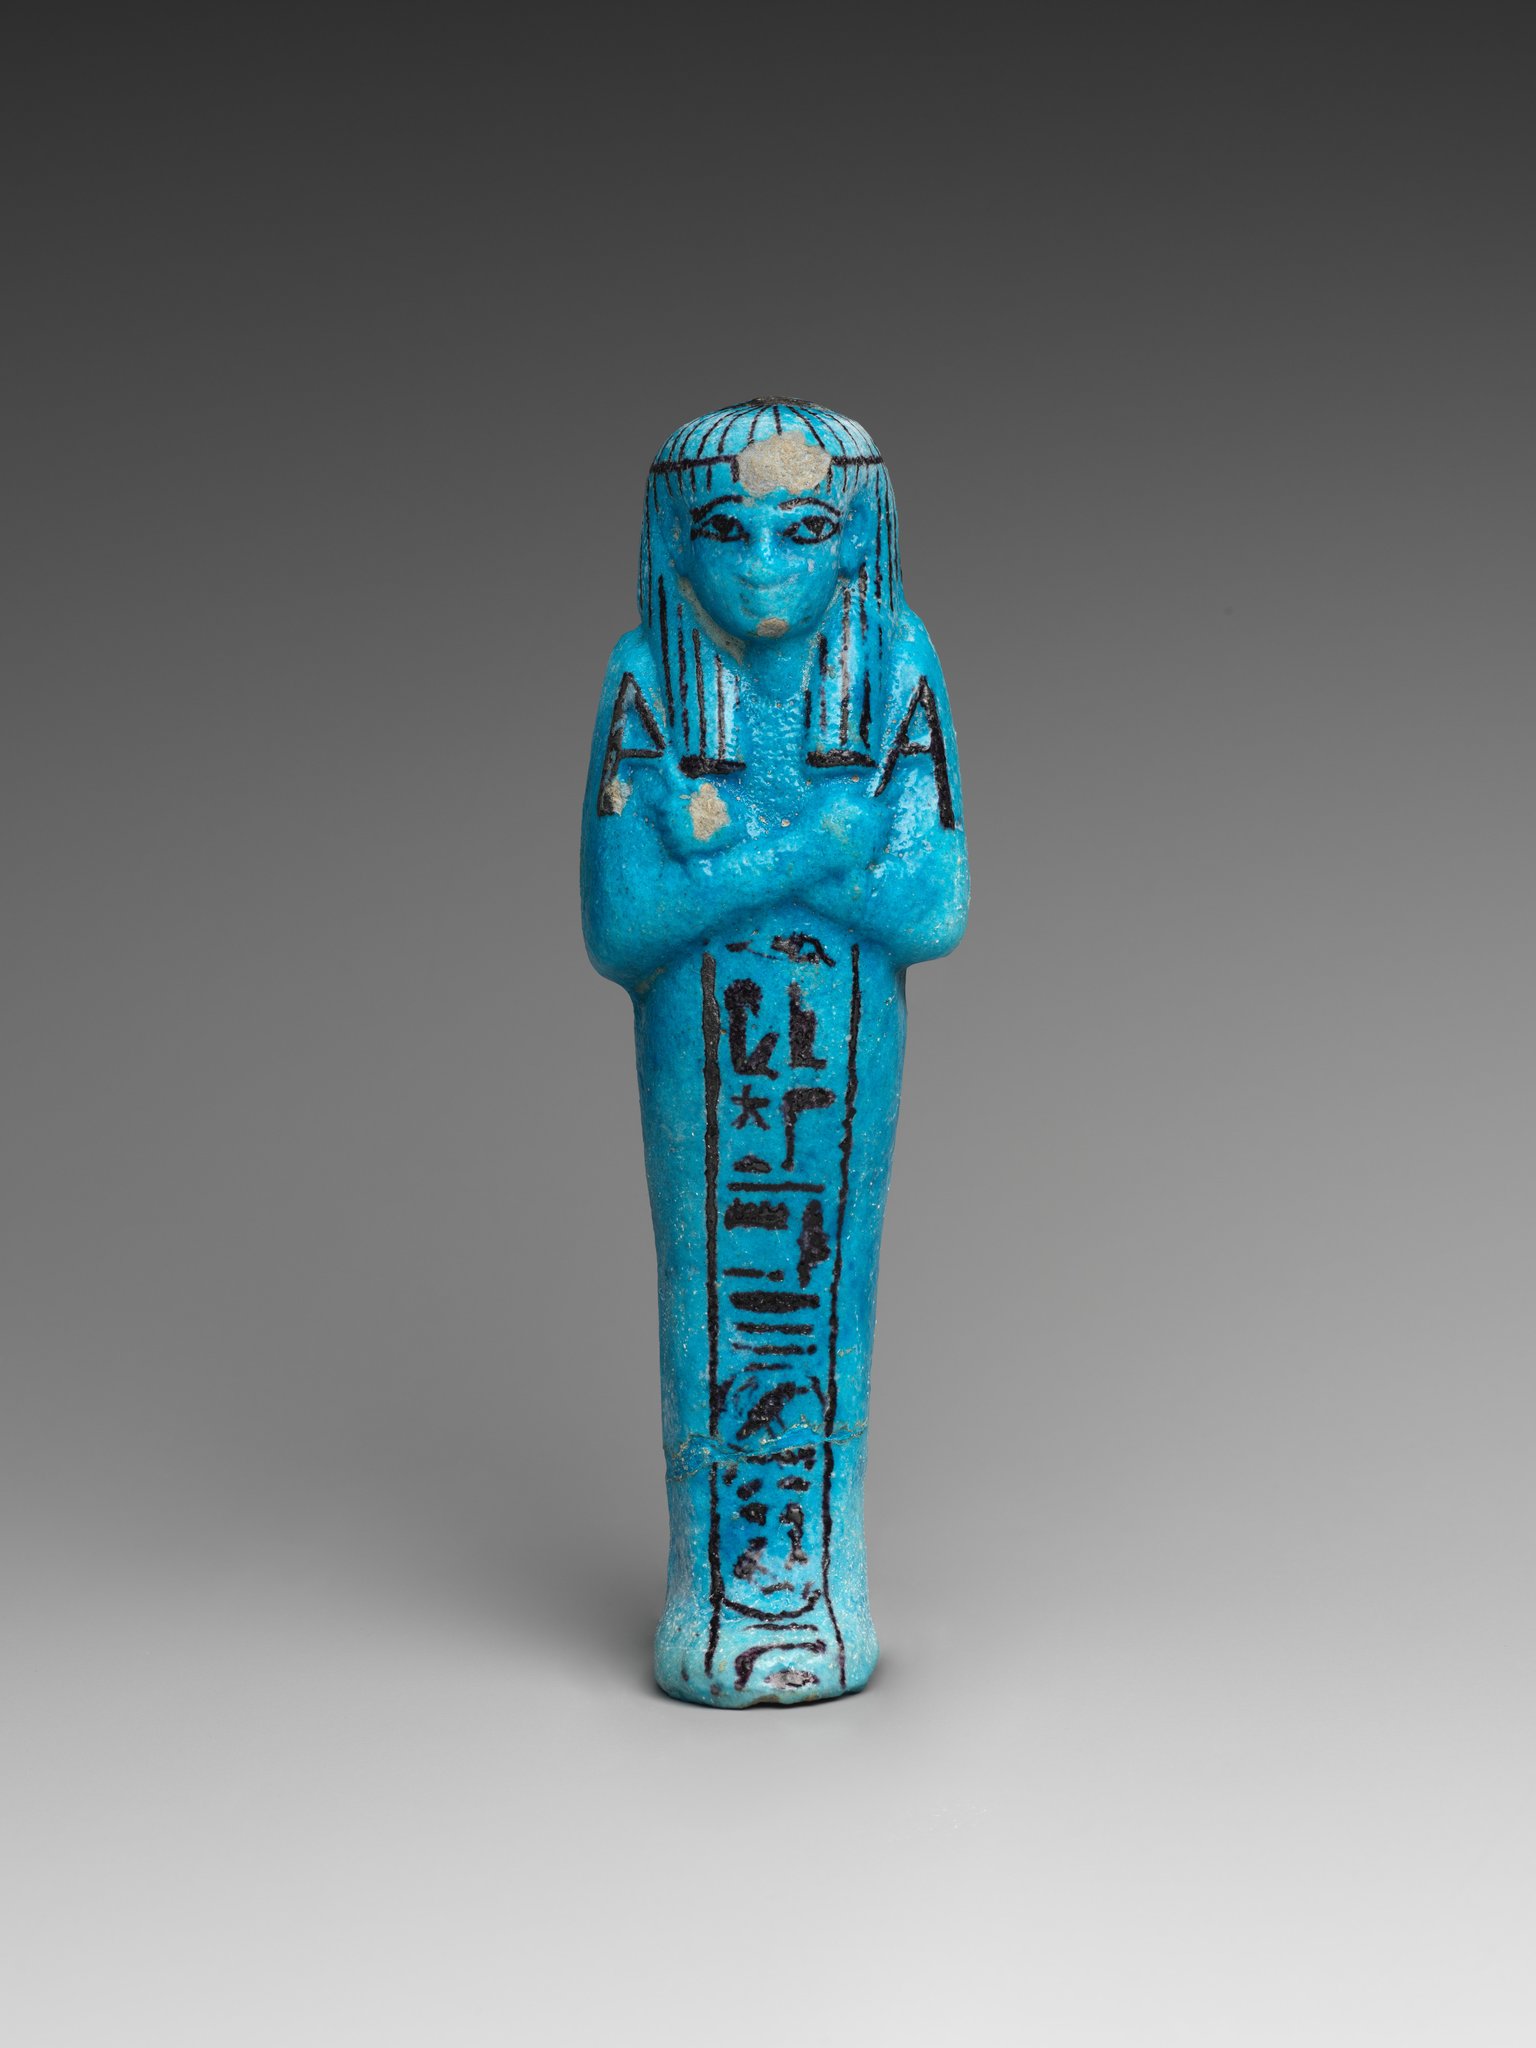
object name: shabti, divine consort, mutemhat mehytenweskhet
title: Shabti of the Divine Consort Mutemhat Mehytenweskhet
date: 945-924 BCE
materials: faience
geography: egypt